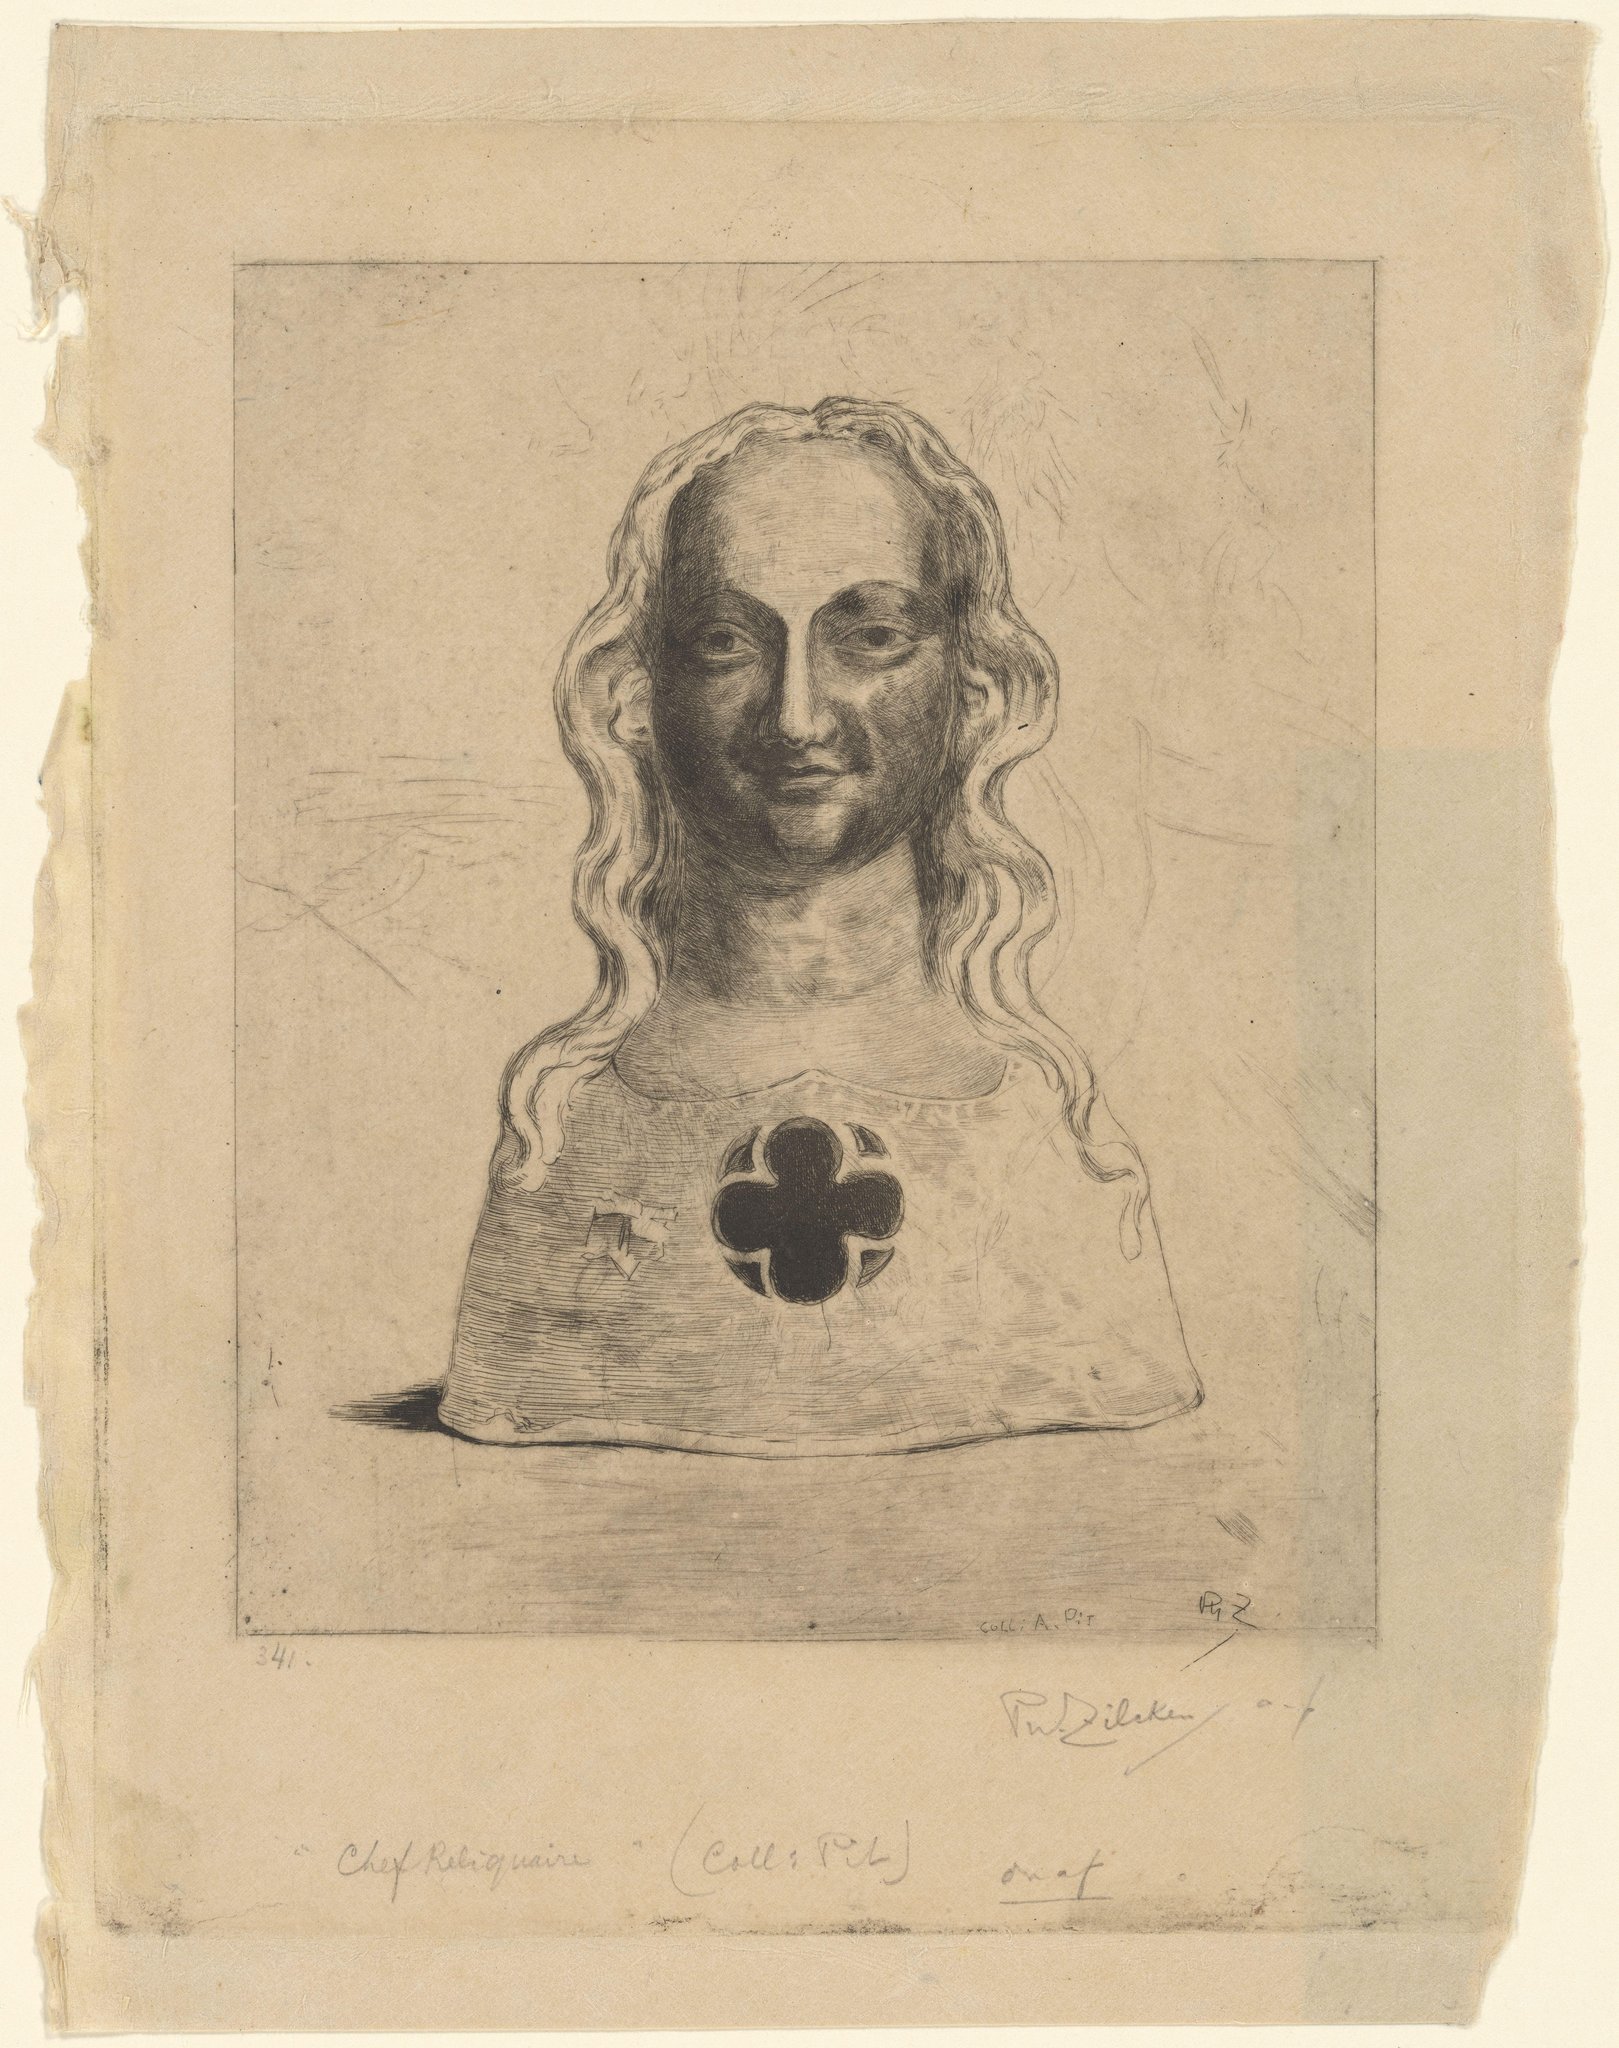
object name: print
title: Buste van een vrouw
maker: philip zilcken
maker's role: draughtsman, painter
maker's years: 1857-1930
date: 1890-1930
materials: paper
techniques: drypoint, etching, intaglio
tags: relics (and reliquaries), chest, bust - aa - female human figure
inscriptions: collector's mark: Lugt 2760, collector's mark: Lugt 2228